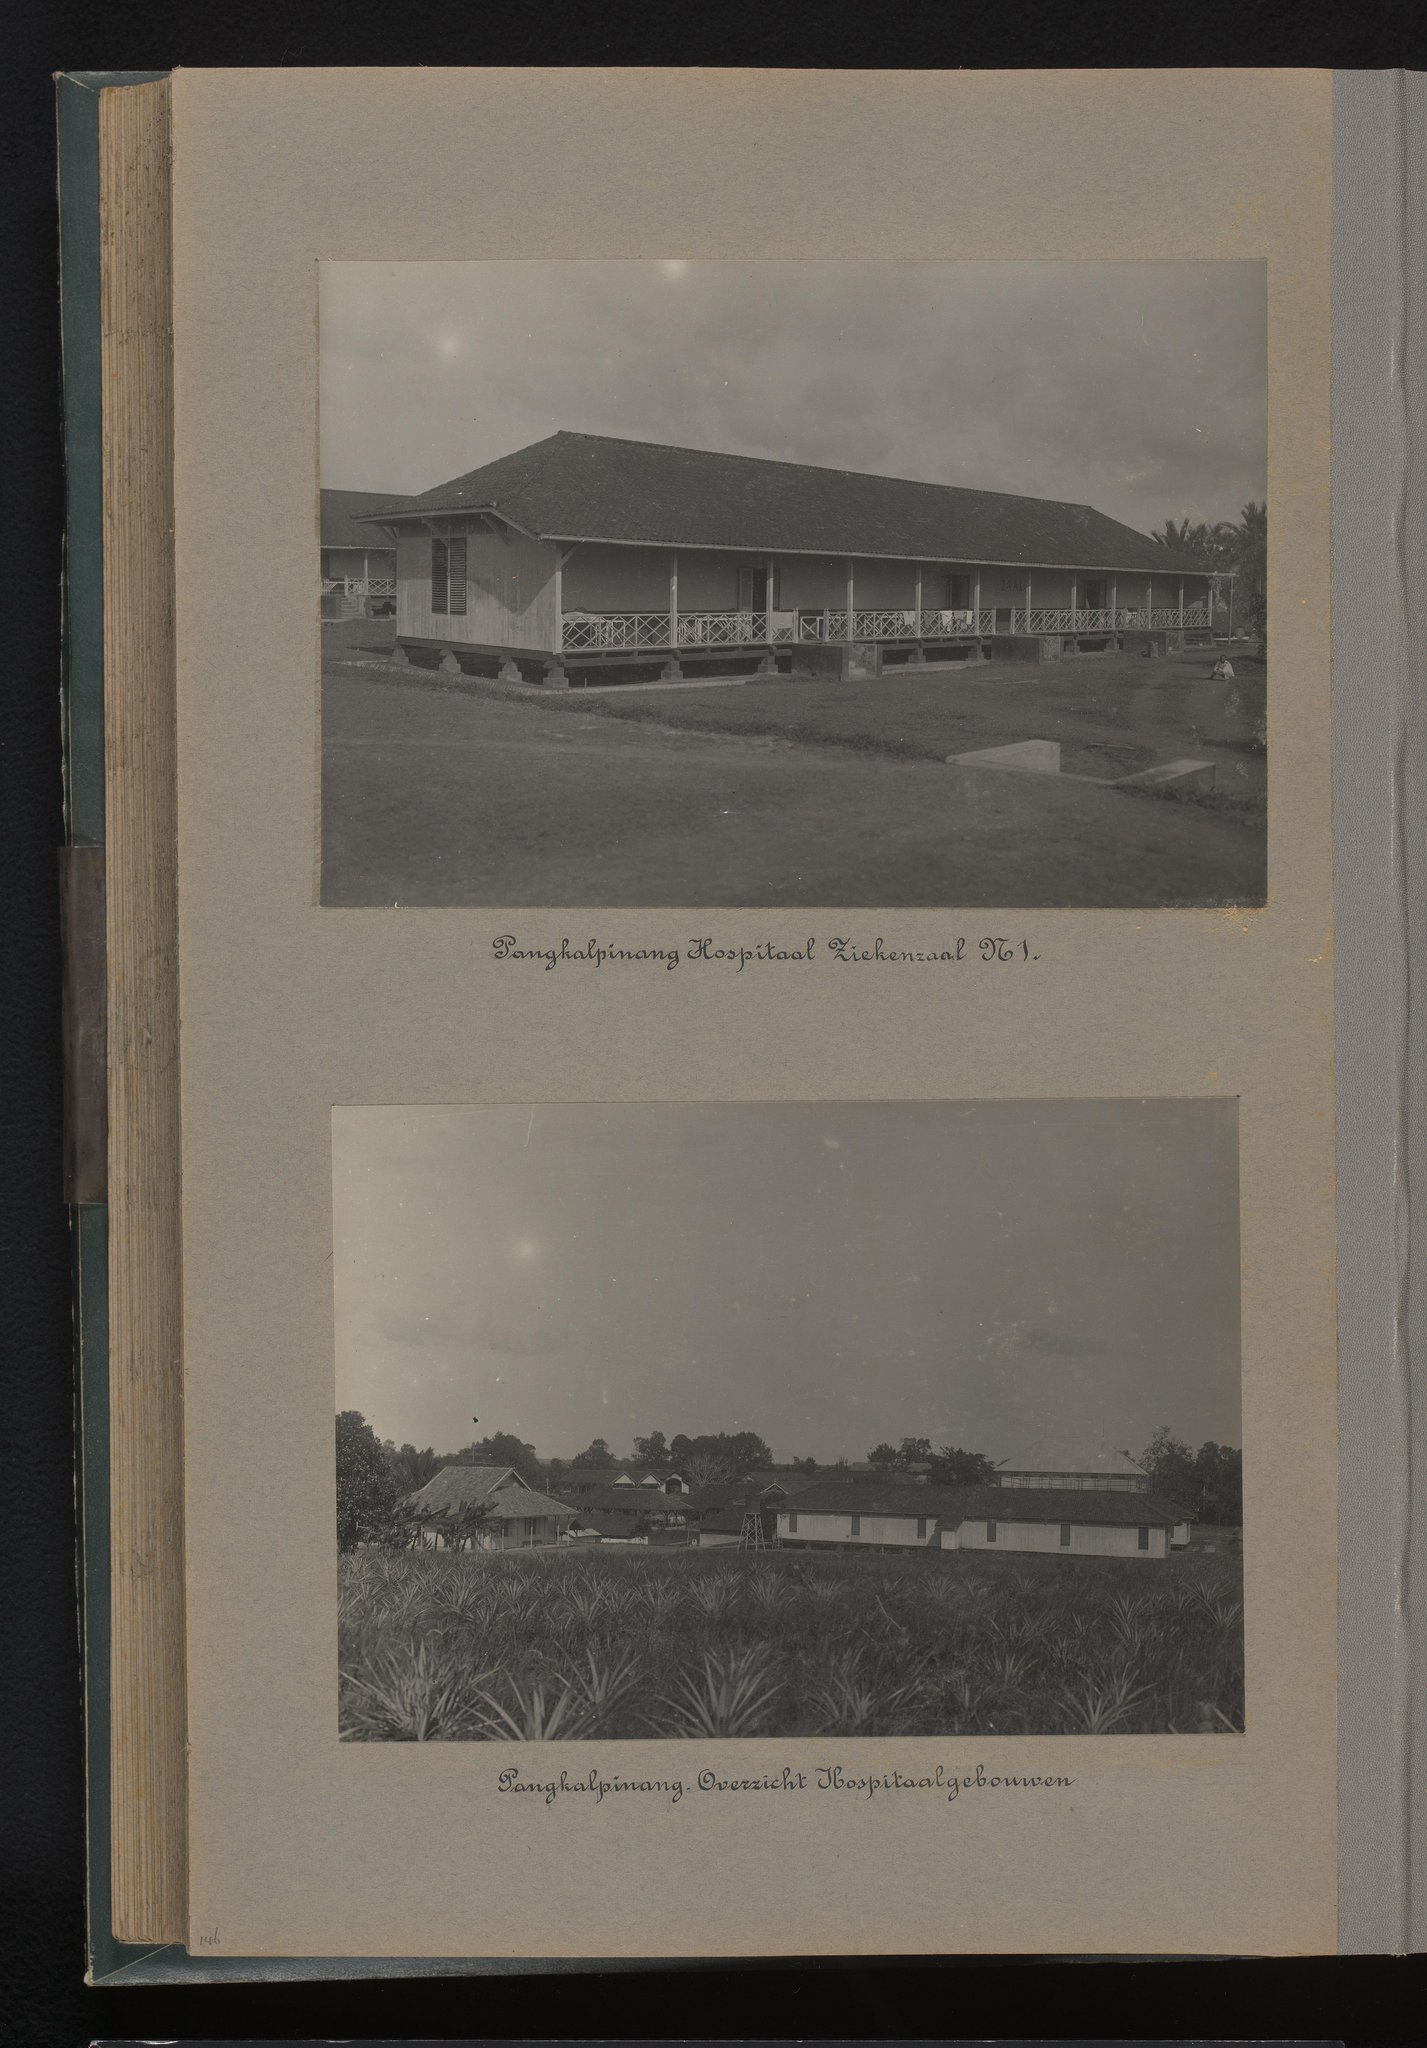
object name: album leaf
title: Hospitaalgebouwen te Pangkalpinang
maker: Anonymous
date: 1914-1919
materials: cardboard, photographic support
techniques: gelatin silver print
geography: bangka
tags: robert julius boers, colonial system, mining, hospital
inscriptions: inscription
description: Albumblad met 2 foto's van de hospitaalgebouwen van de mijnbouwonderneming te Pangkalpinang. Onderdeel van het fotoalbum aangeboden aan Robert Julius Boers bij zijn vertrek naar Nederland in 1919 door het personeel van de Banka-tinwinning.